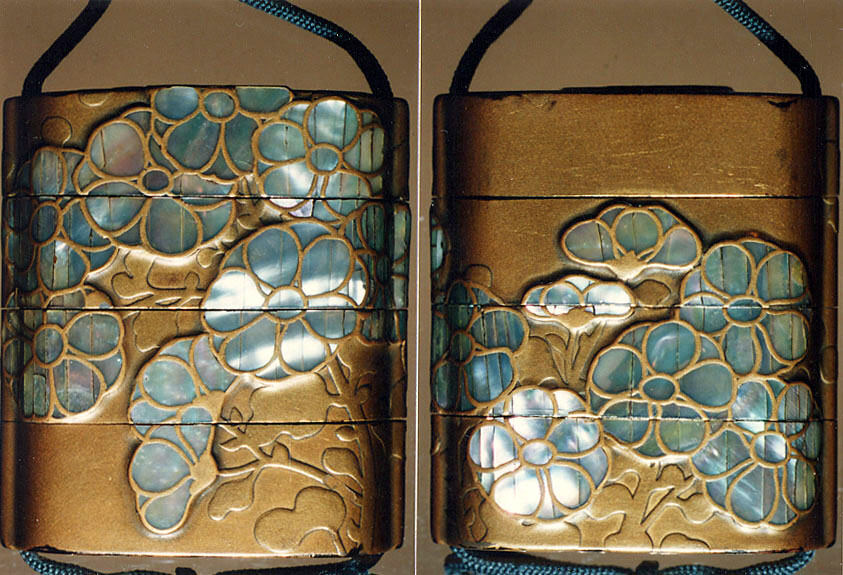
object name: inrō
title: Case (Inrō) with Design of Flowering Plants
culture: japanese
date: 1701-1800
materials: gold, lacquer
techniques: fundame, inlay, maki-e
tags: flowers